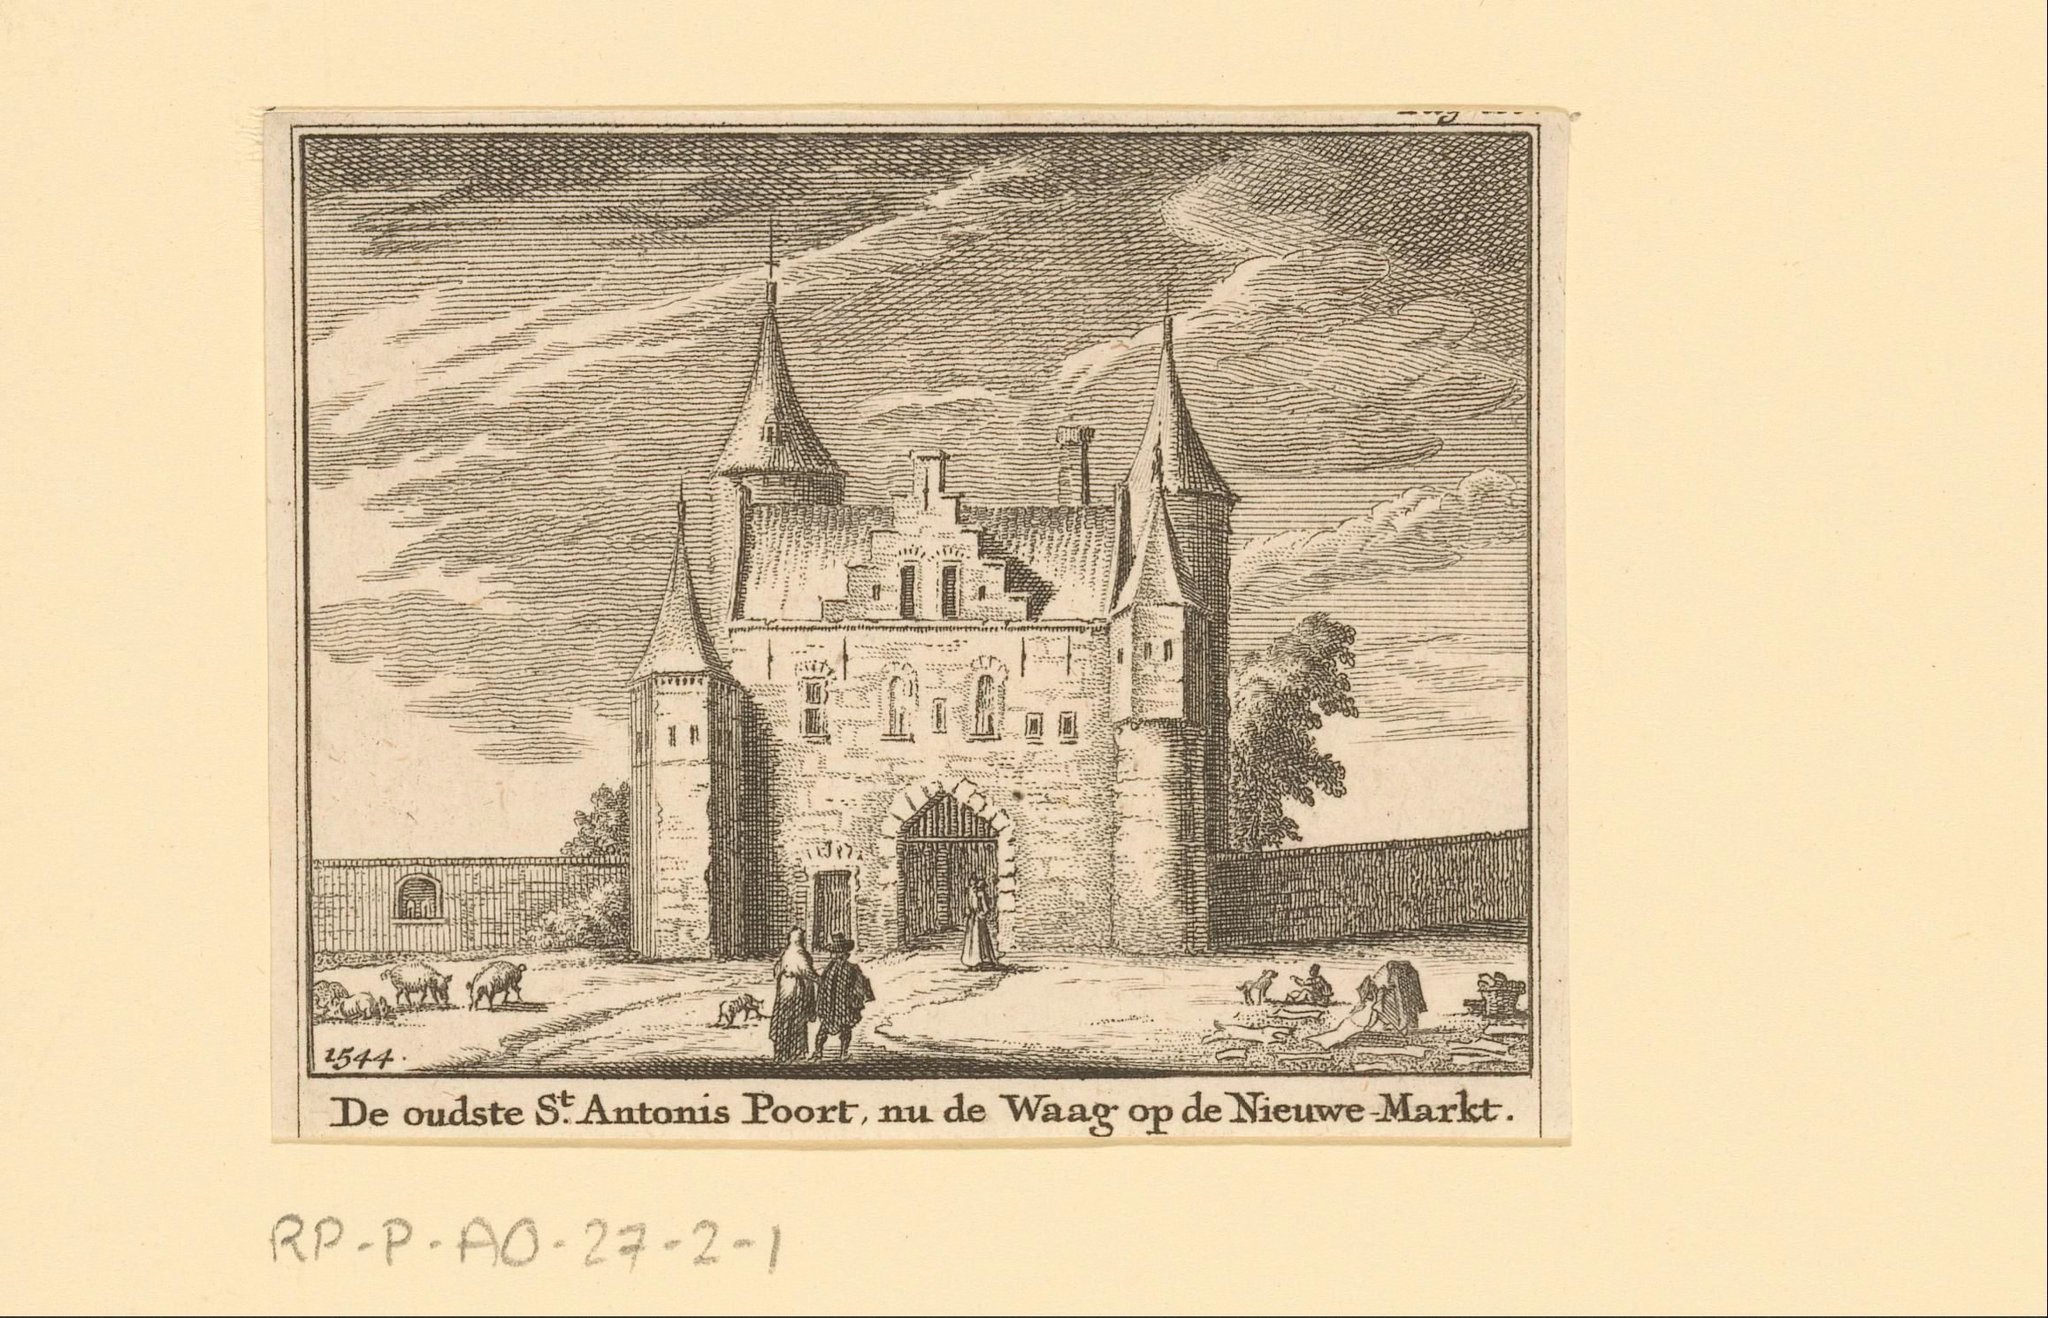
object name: print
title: De oudste St. Antonis Poort, nu de Waag op de Nieuwe Markt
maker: jan goeree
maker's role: draughtsman, print maker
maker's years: 1670-1731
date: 1723-1738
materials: paper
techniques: engraving, etching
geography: amsterdam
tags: city-gate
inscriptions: collector's mark: Lugt 195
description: Prent ook gebruikt in: Willink, Daniël. Amsterdamsche Buitensingel nevens de omleggende dorpen, opgeheldert door aanteekeningen over veele voornaame geschiedeniszen: met afbeeldingen (…) / Daniël Willinks Amsterdamsche Buitensingel. Amsterdam: Andries van Damme, 1723. En in: Willink, Daniël. Amsterdamsche Buitensingel nevens de omleggende dorpen, opgeheldert door aanteekeningen over veele voornaame geschiedenissen: met afbeeldingen (…) / Daniël Willinks Amsterdamsche Buitensingel. Amsterdam: Arend van Huyssteen, 1738.